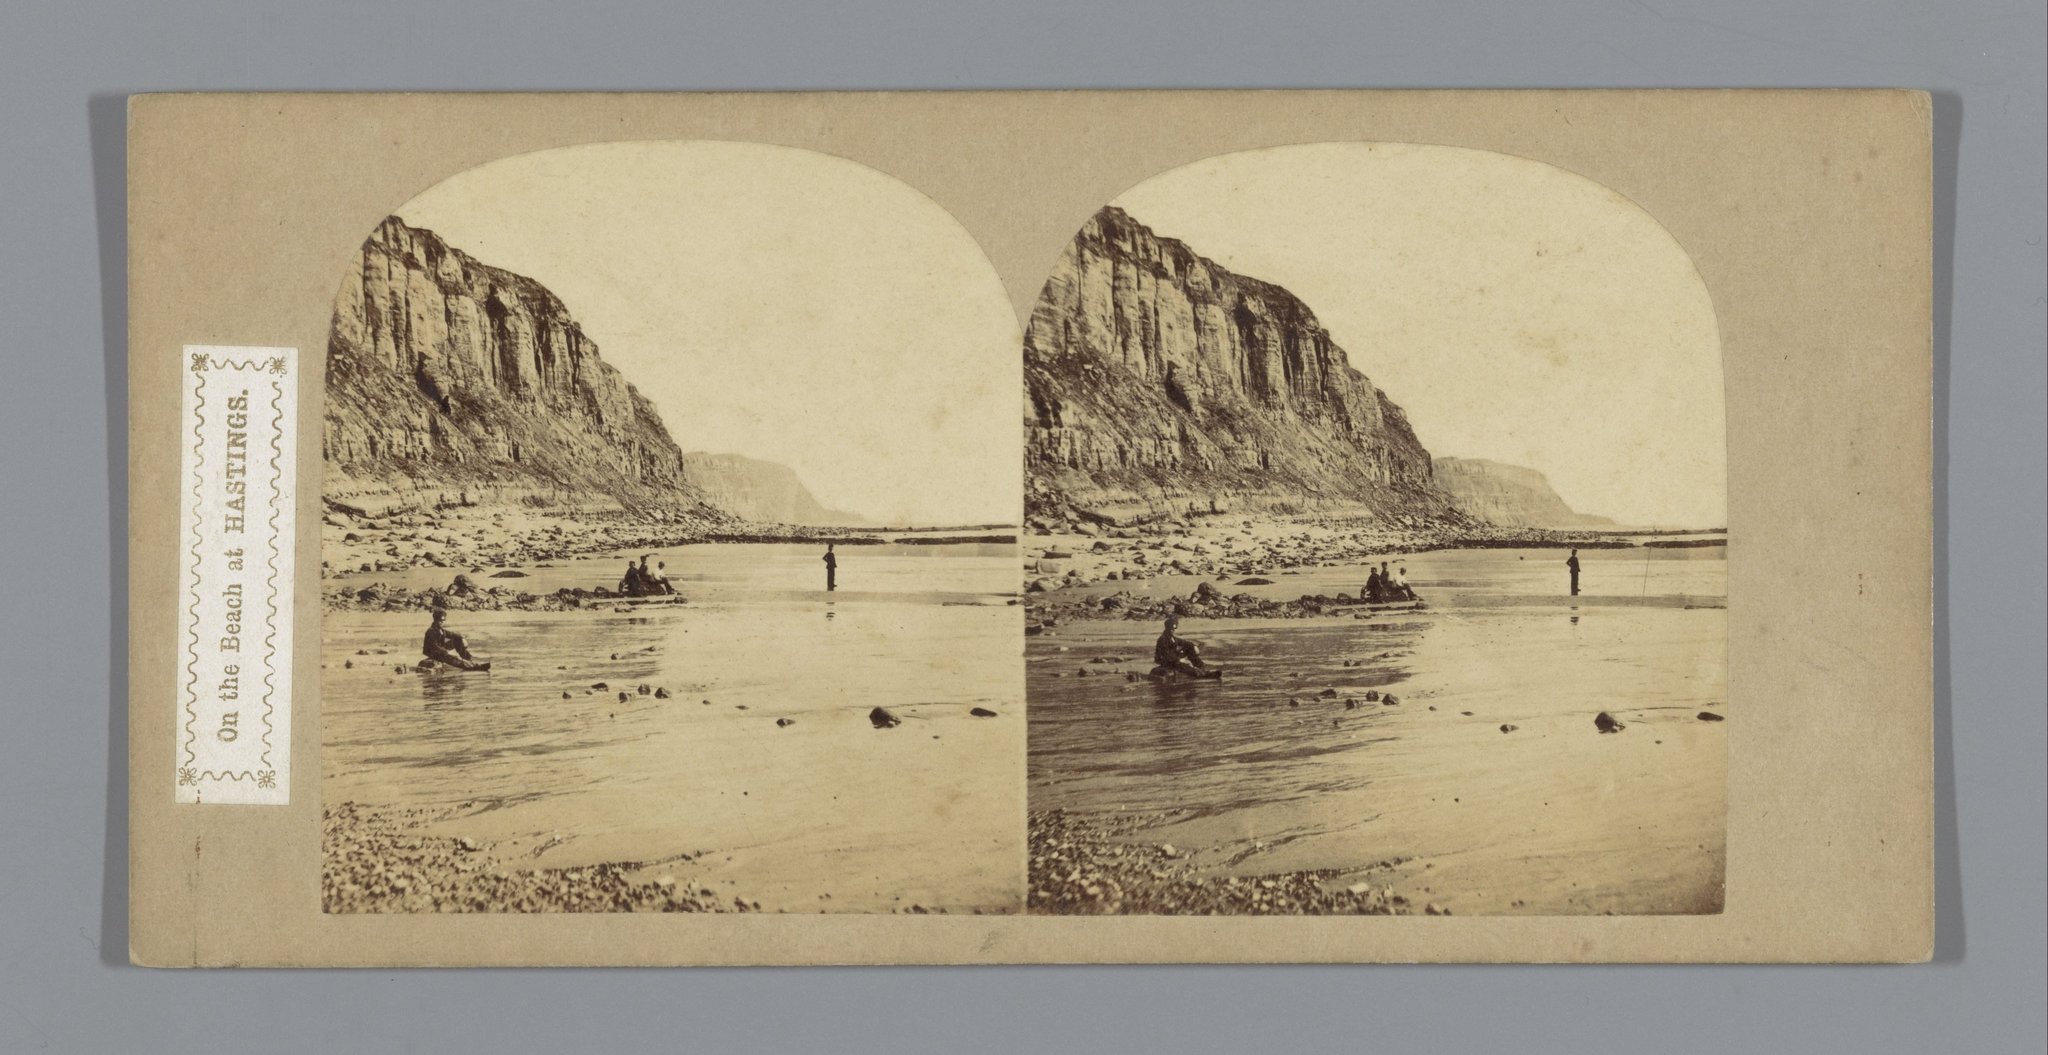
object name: stereograph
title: On the Beach at Hastings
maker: Anonymous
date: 1860-1865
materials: cardboard, photographic support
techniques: albumen print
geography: hastings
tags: rocky coast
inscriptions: number: ‘80’